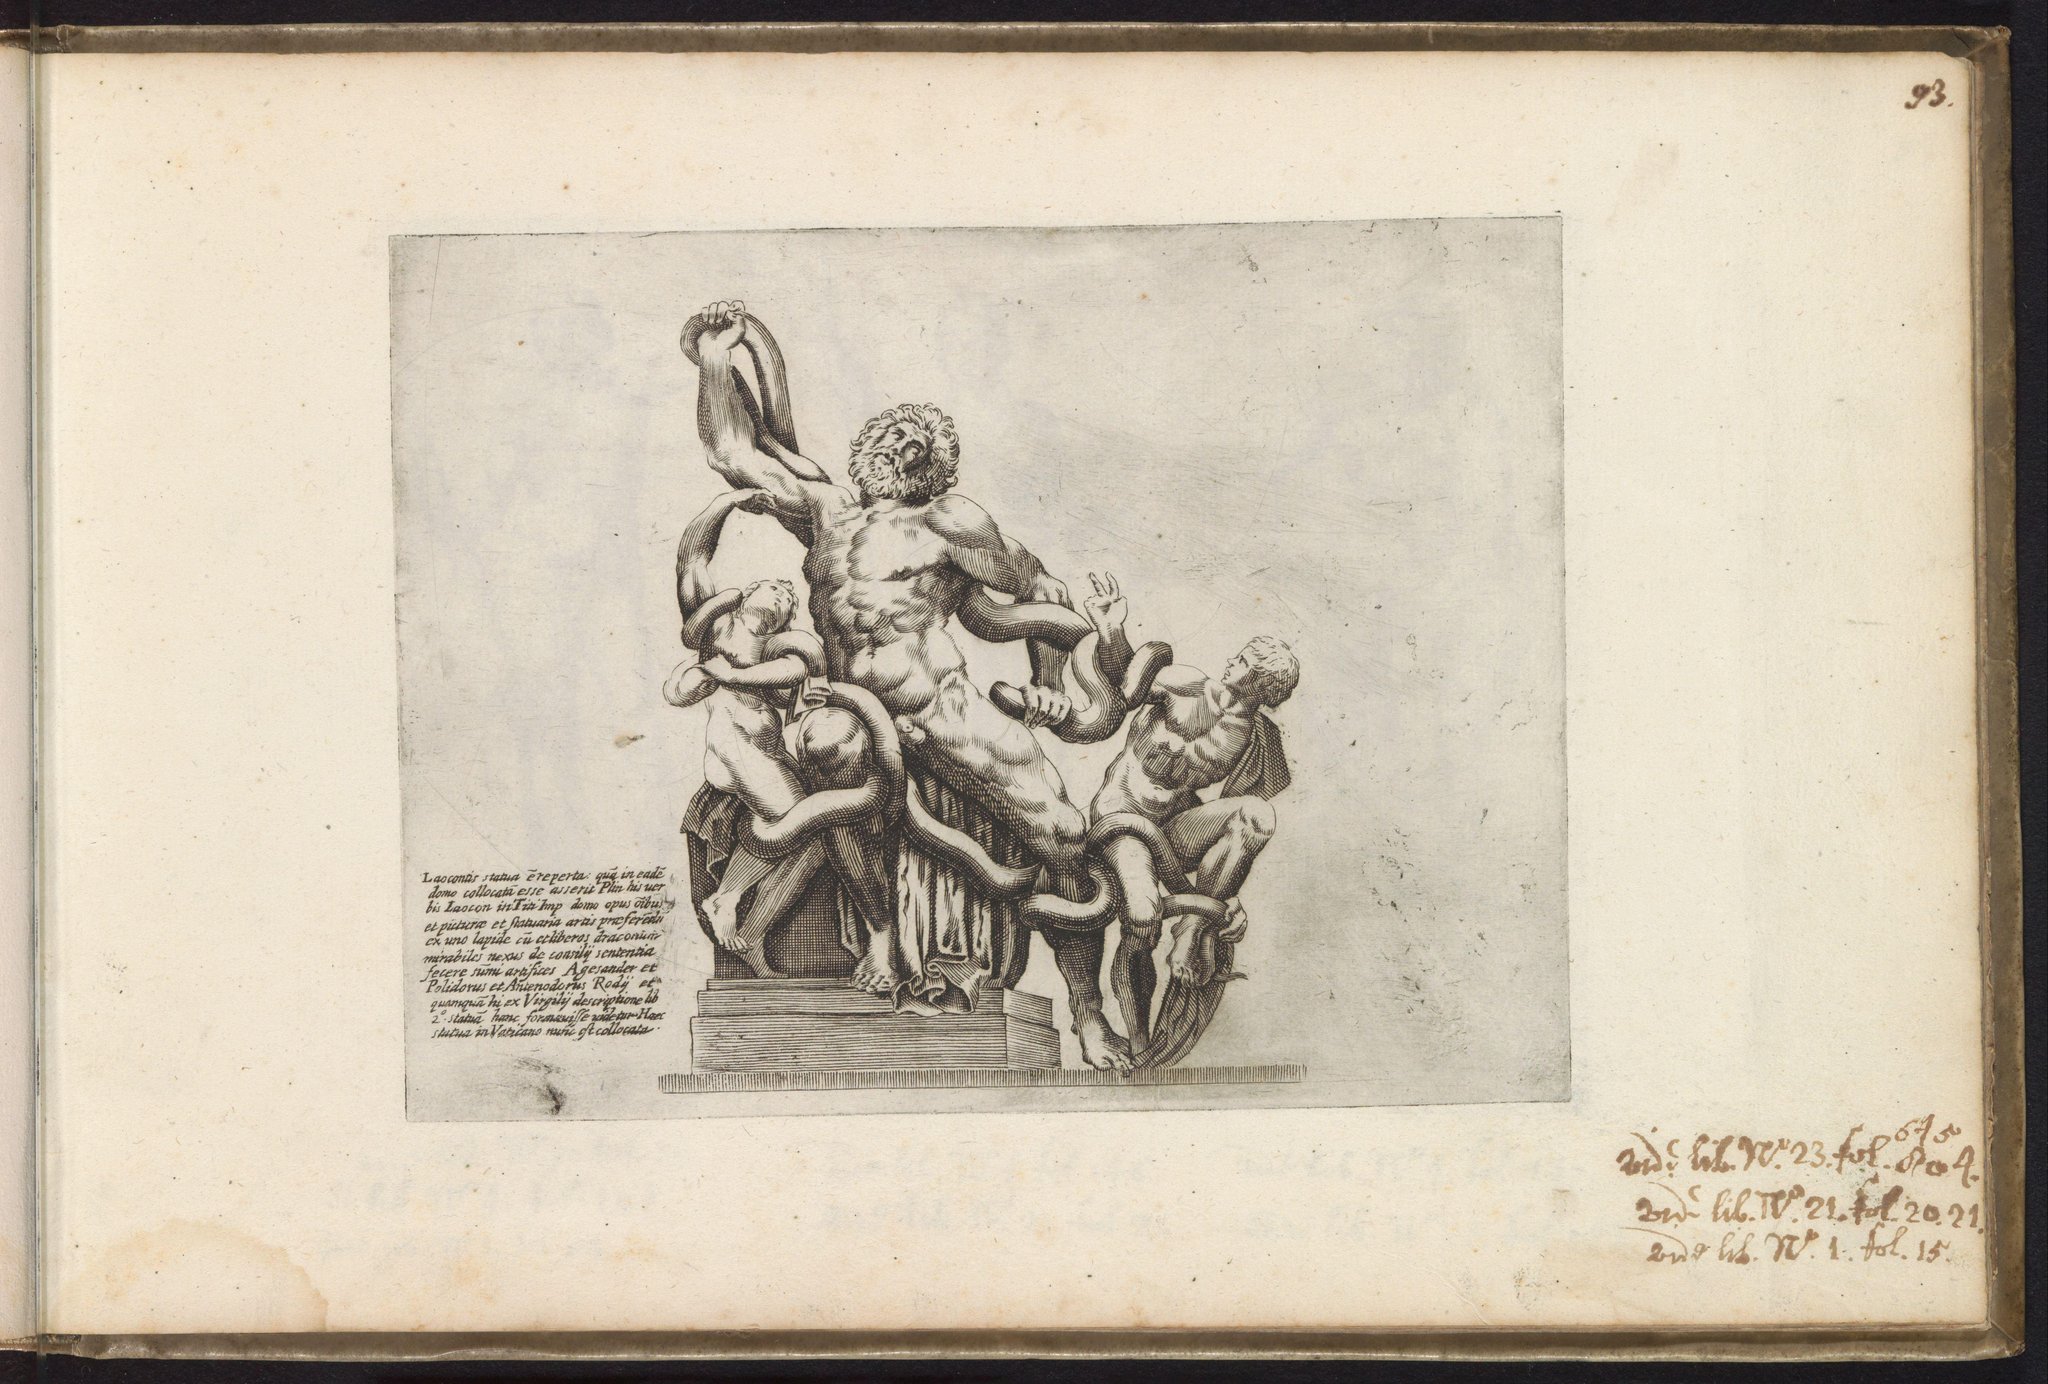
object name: print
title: Sculpturen uit de oudheid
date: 1538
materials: paper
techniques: engraving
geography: rome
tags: laocoon and his twin sons are strangled by two serpents during the preparations for a sacrifice, piece of sculpture, reproduction of a piece of sculpture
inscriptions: number: ‘93’, inscription: ‘Ende lib. No. 23. fol. 645/ 804./ Ende lib. No. 21. fol. 20. 21./ Ende lib. No. 1. fol. 15.’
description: Deze prent maakt deel uit van een reeks van ten minste 19 prenten van sculpturen uit de oudheid. Deze beeldengroep bevindt zich in de Cortile del Belvedere in de Vaticaanse Musea.